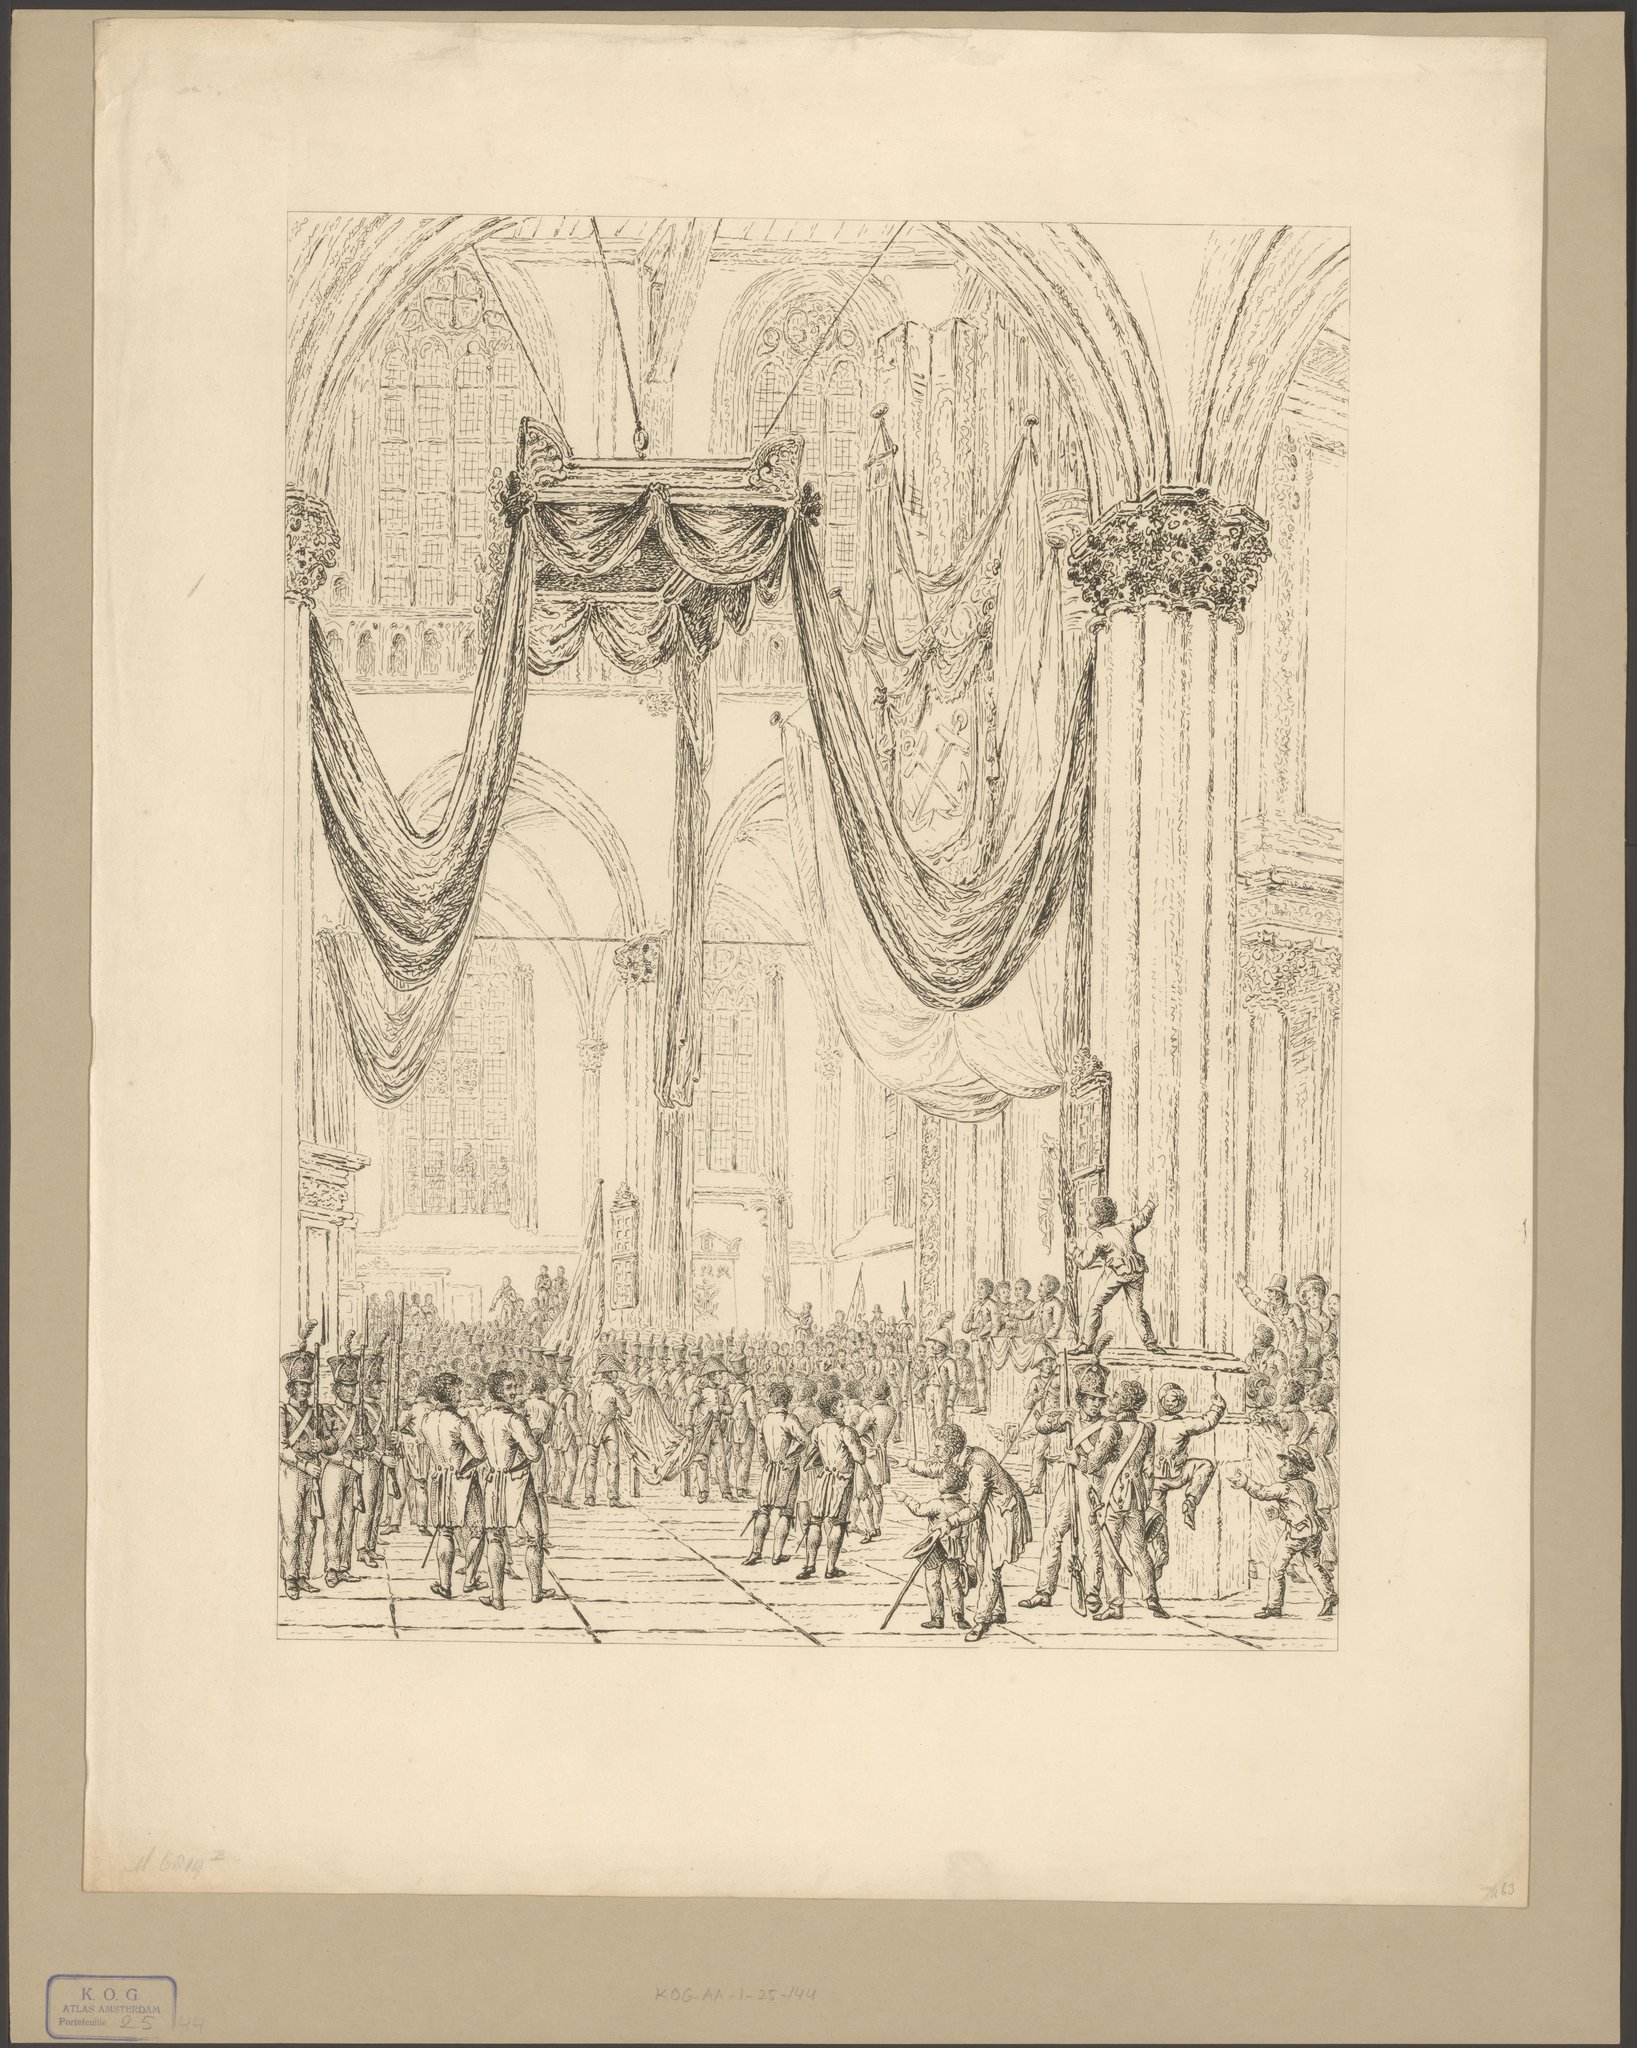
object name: print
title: Begrafenis van J.C.J. van Speyk in vier platen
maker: johannes jelgerhuis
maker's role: draughtsman, painter, print maker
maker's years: 1770-1836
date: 1832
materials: paper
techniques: etching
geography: amsterdam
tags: amsterdam, antwerp, jan van speyk, cortege, funeral procession, commander-in-chief, admiral, historical person (with name)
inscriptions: collector's mark: ‘25.144’ Lugt 1641b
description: Onderwerpsrubriek binnen de Atlas Amsterdam: Krijgswezen I: De Admiraliteit van Amsterdam, D. J.C. van Speyk.